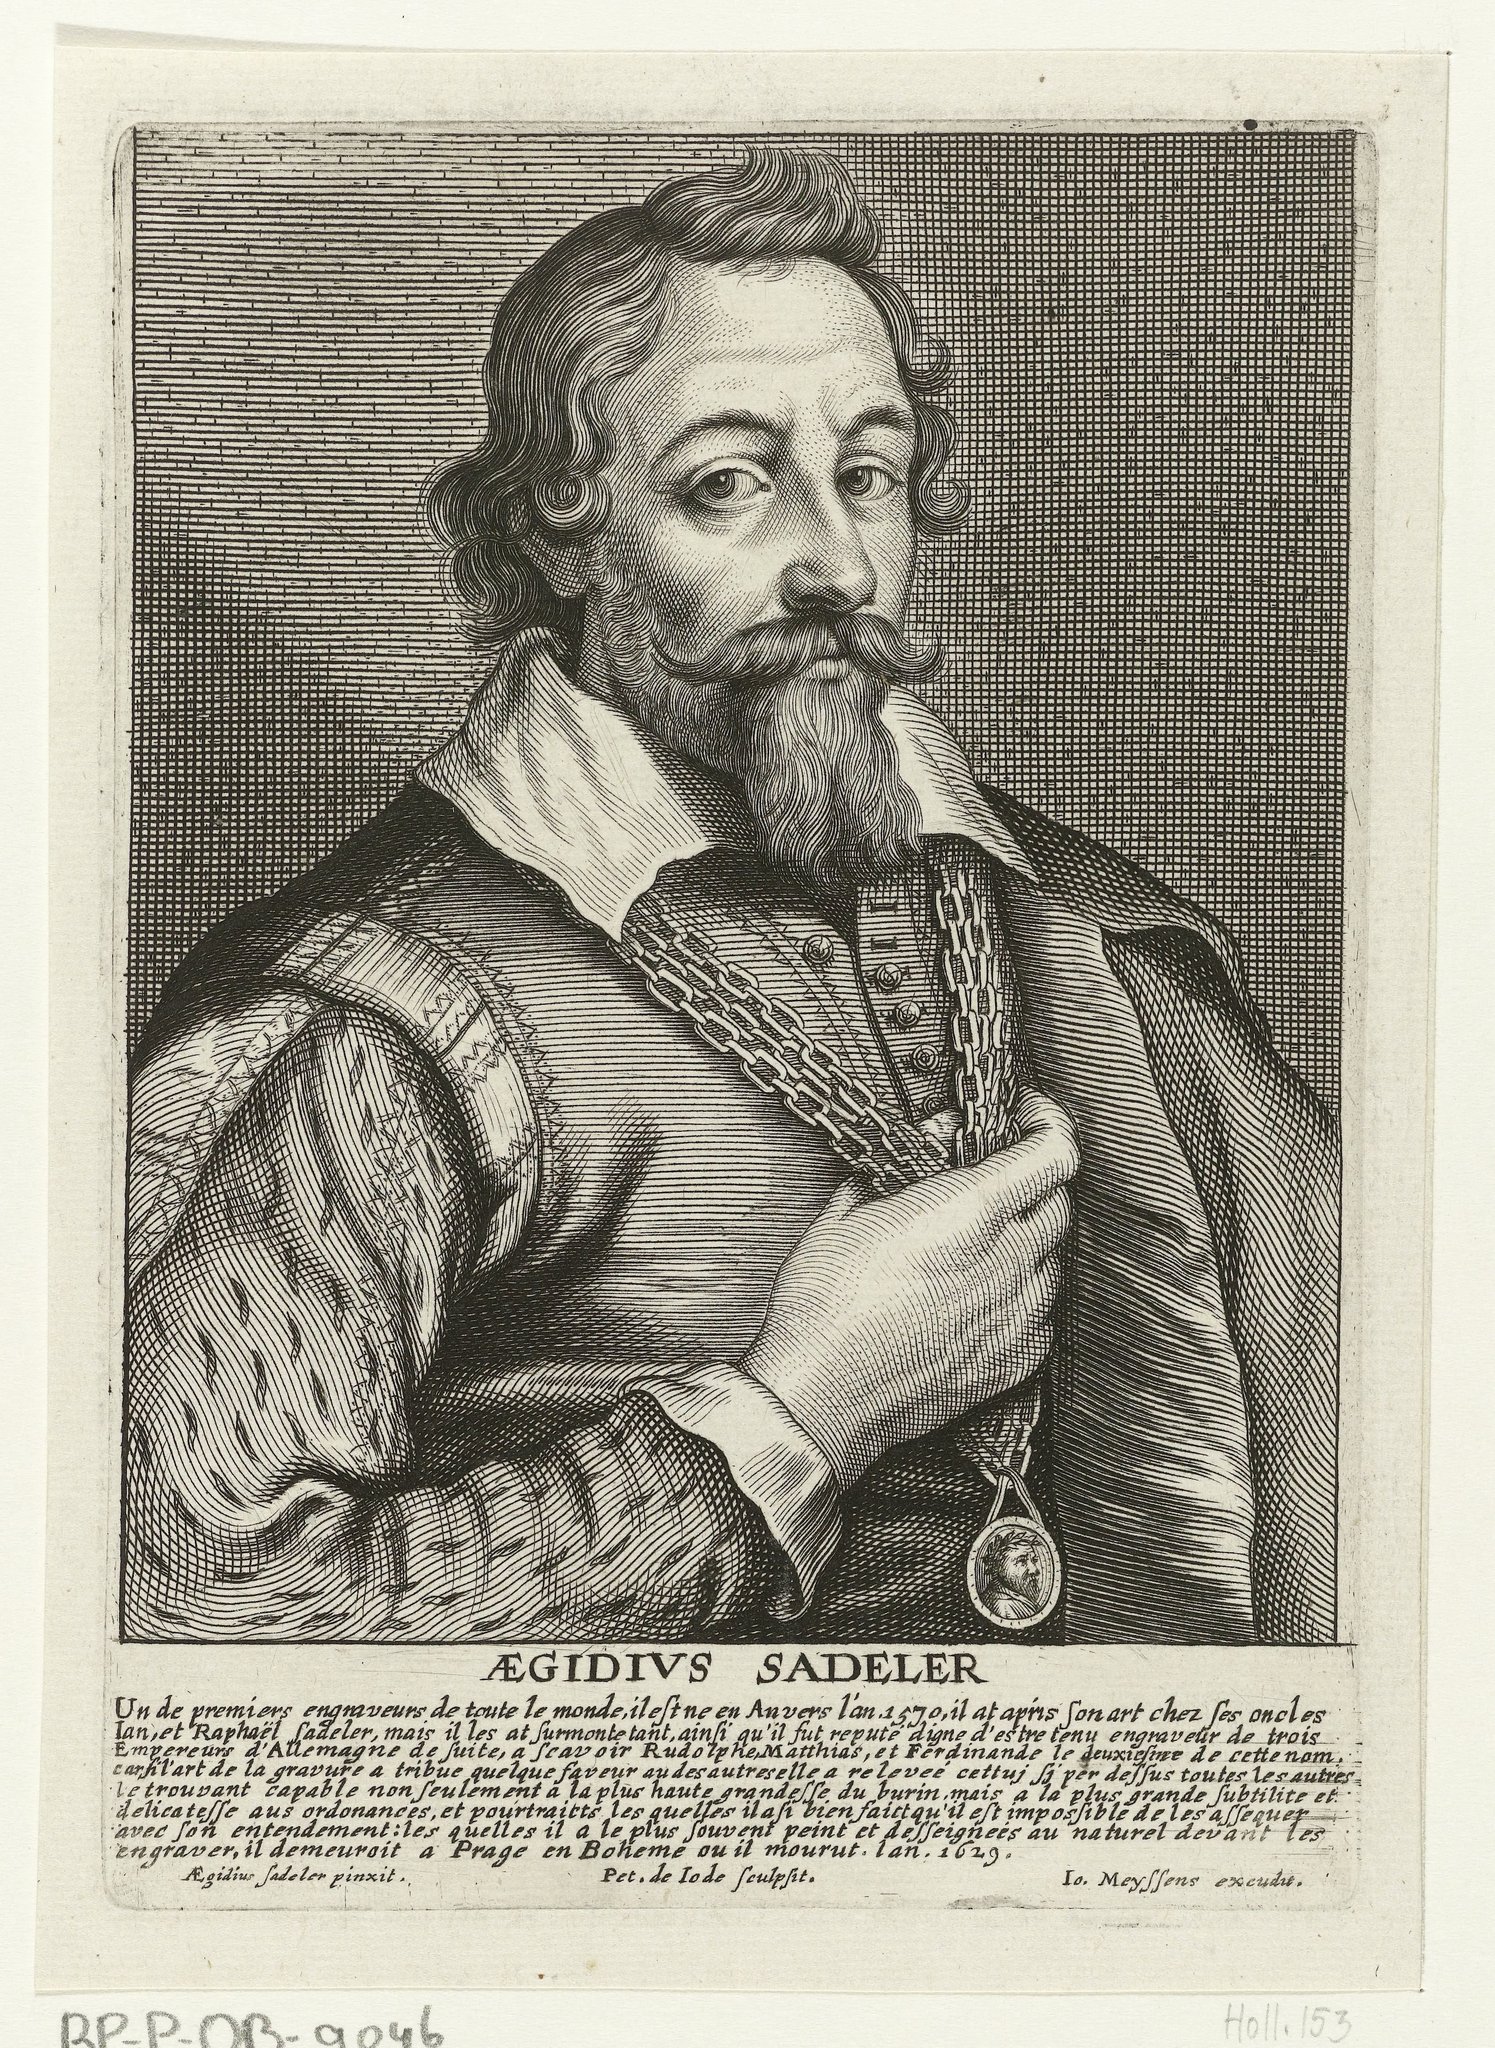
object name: print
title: Portret van Aegidius Sadeler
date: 1628-1670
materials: paper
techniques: engraving, etching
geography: antwerp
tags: antwerp, prague, draughtsman, aegidius sadeler (ii), pendant, trinket, 'breloque'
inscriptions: collector's mark: Lugt 2228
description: Busteportret van Aegidius Sadeler. Hij draagt een keten met een medaillon. In de marge de naam van de geportretteerde en een achtregelig onderschrift in het Frans.